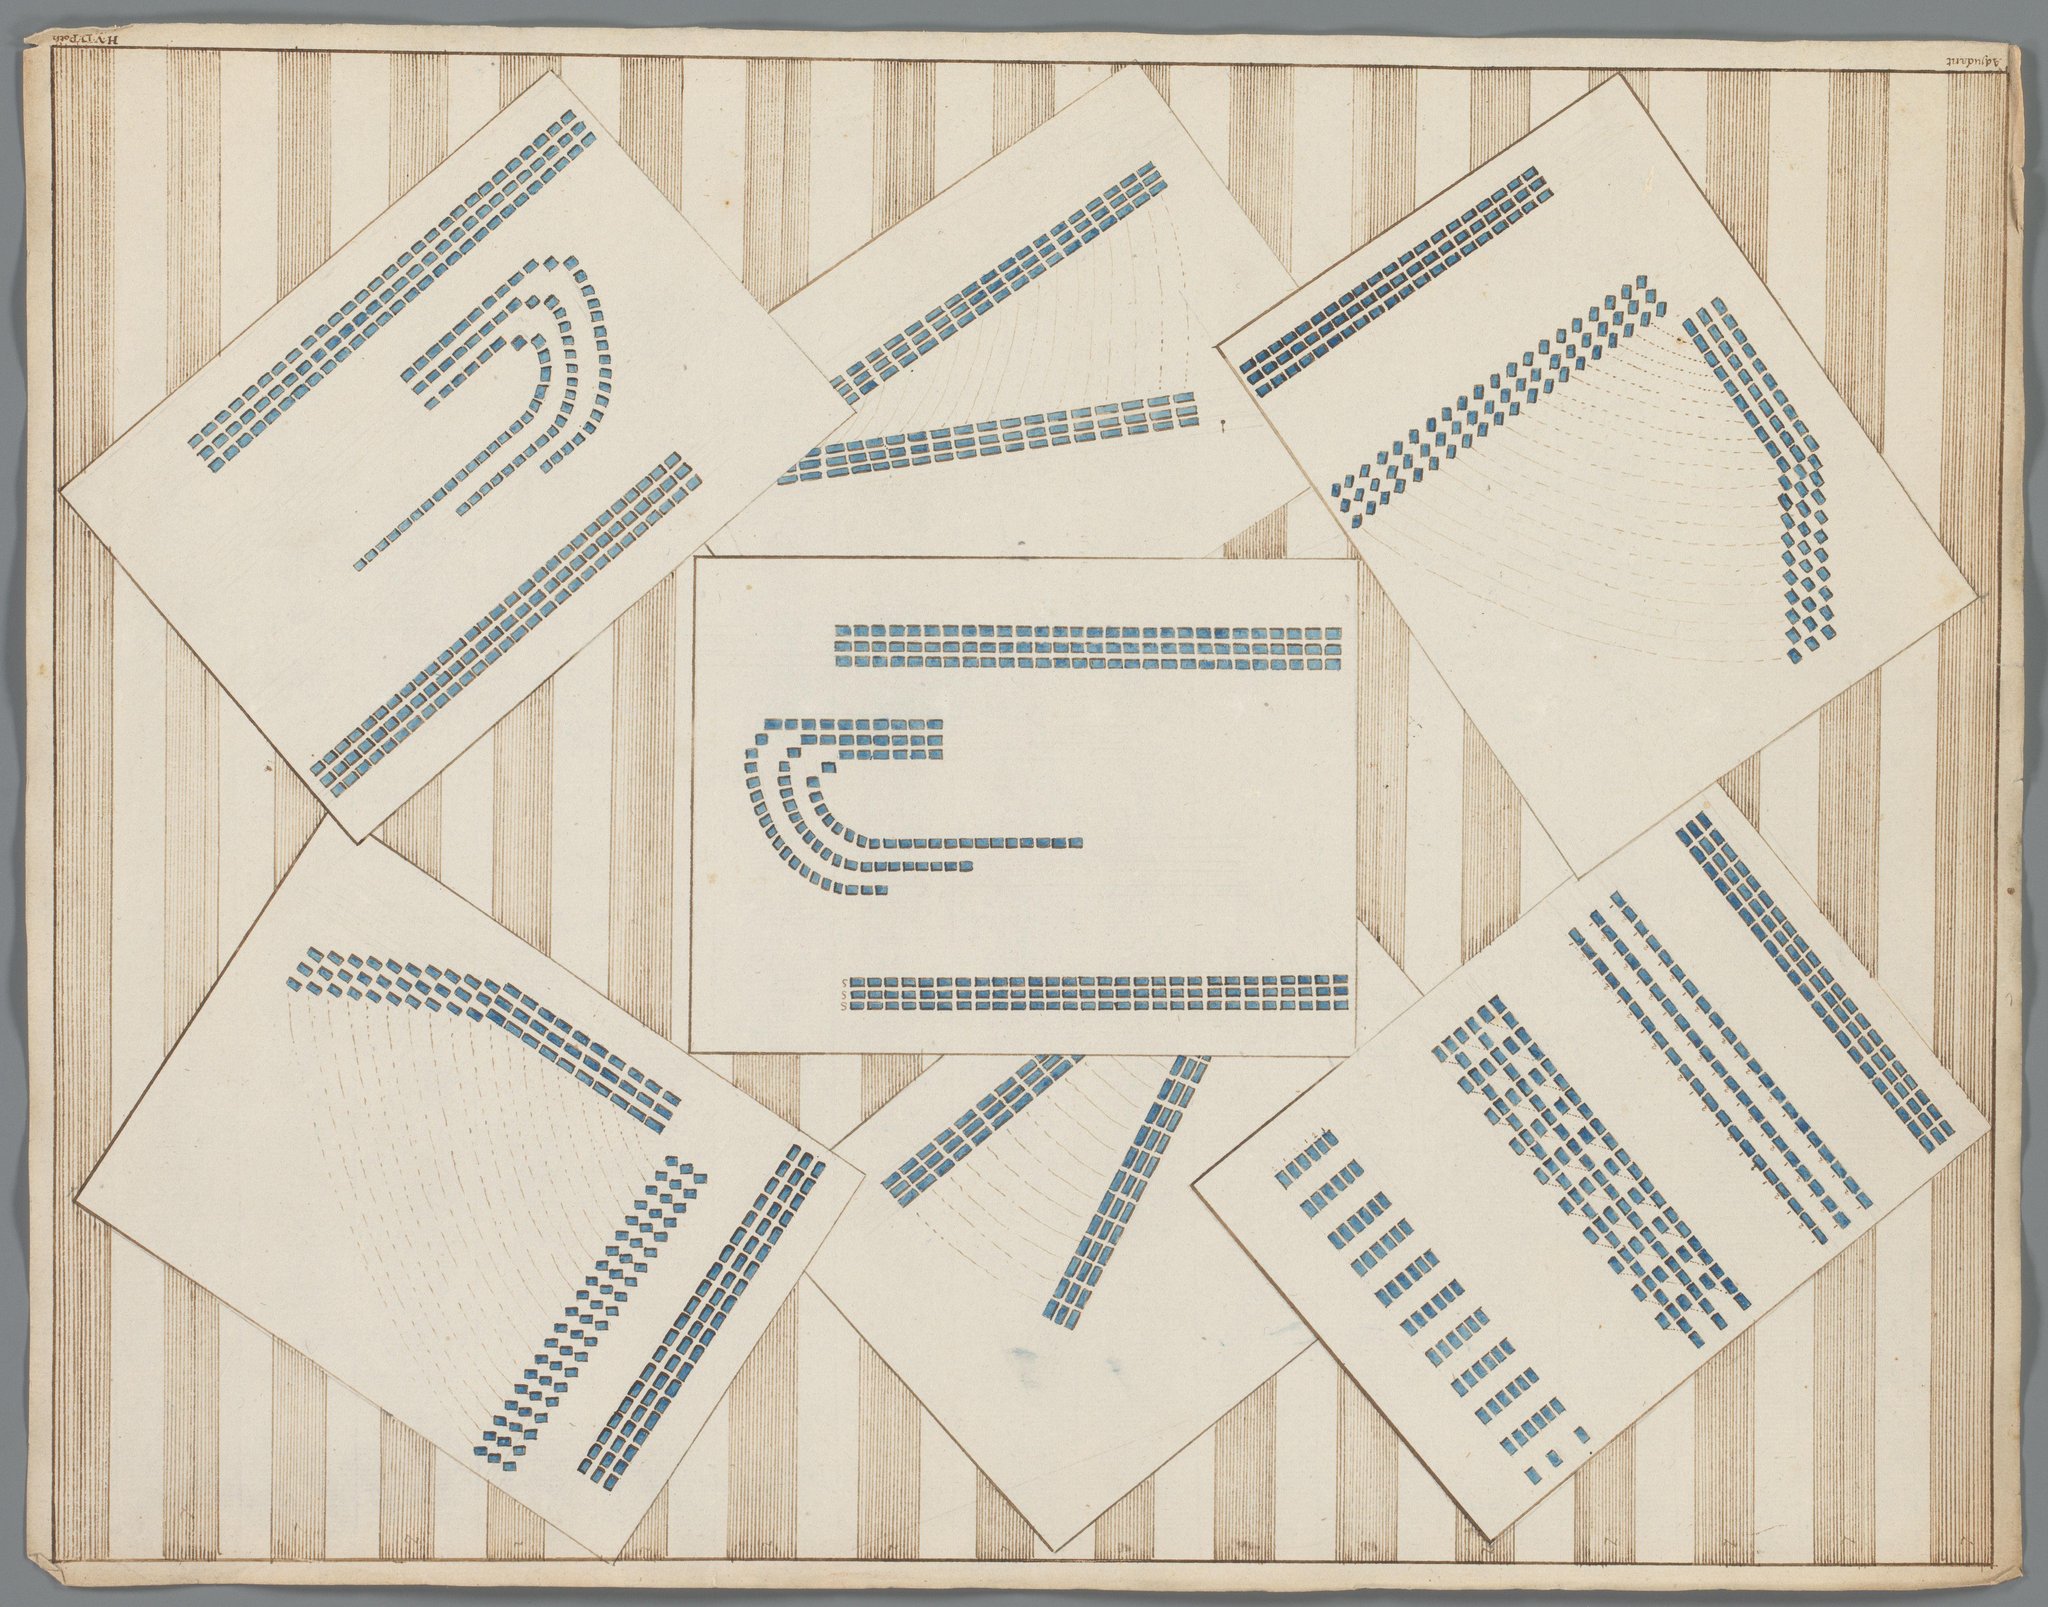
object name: drawing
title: Manoeuvres van de compagnieën, ca. 1799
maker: hendrik van der poth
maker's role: draughtsman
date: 1799-1803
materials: paper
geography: netherlands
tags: manoeuvre ~ military training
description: Blad met zeven kaartjes van verschillende manoeuvres van de zeven compagnieën van het Bataafse bataljon. Ten tijde van de Brits-Russische expeditie in 1799. Onderdeel van een groep van zeventien getekende kaarten.